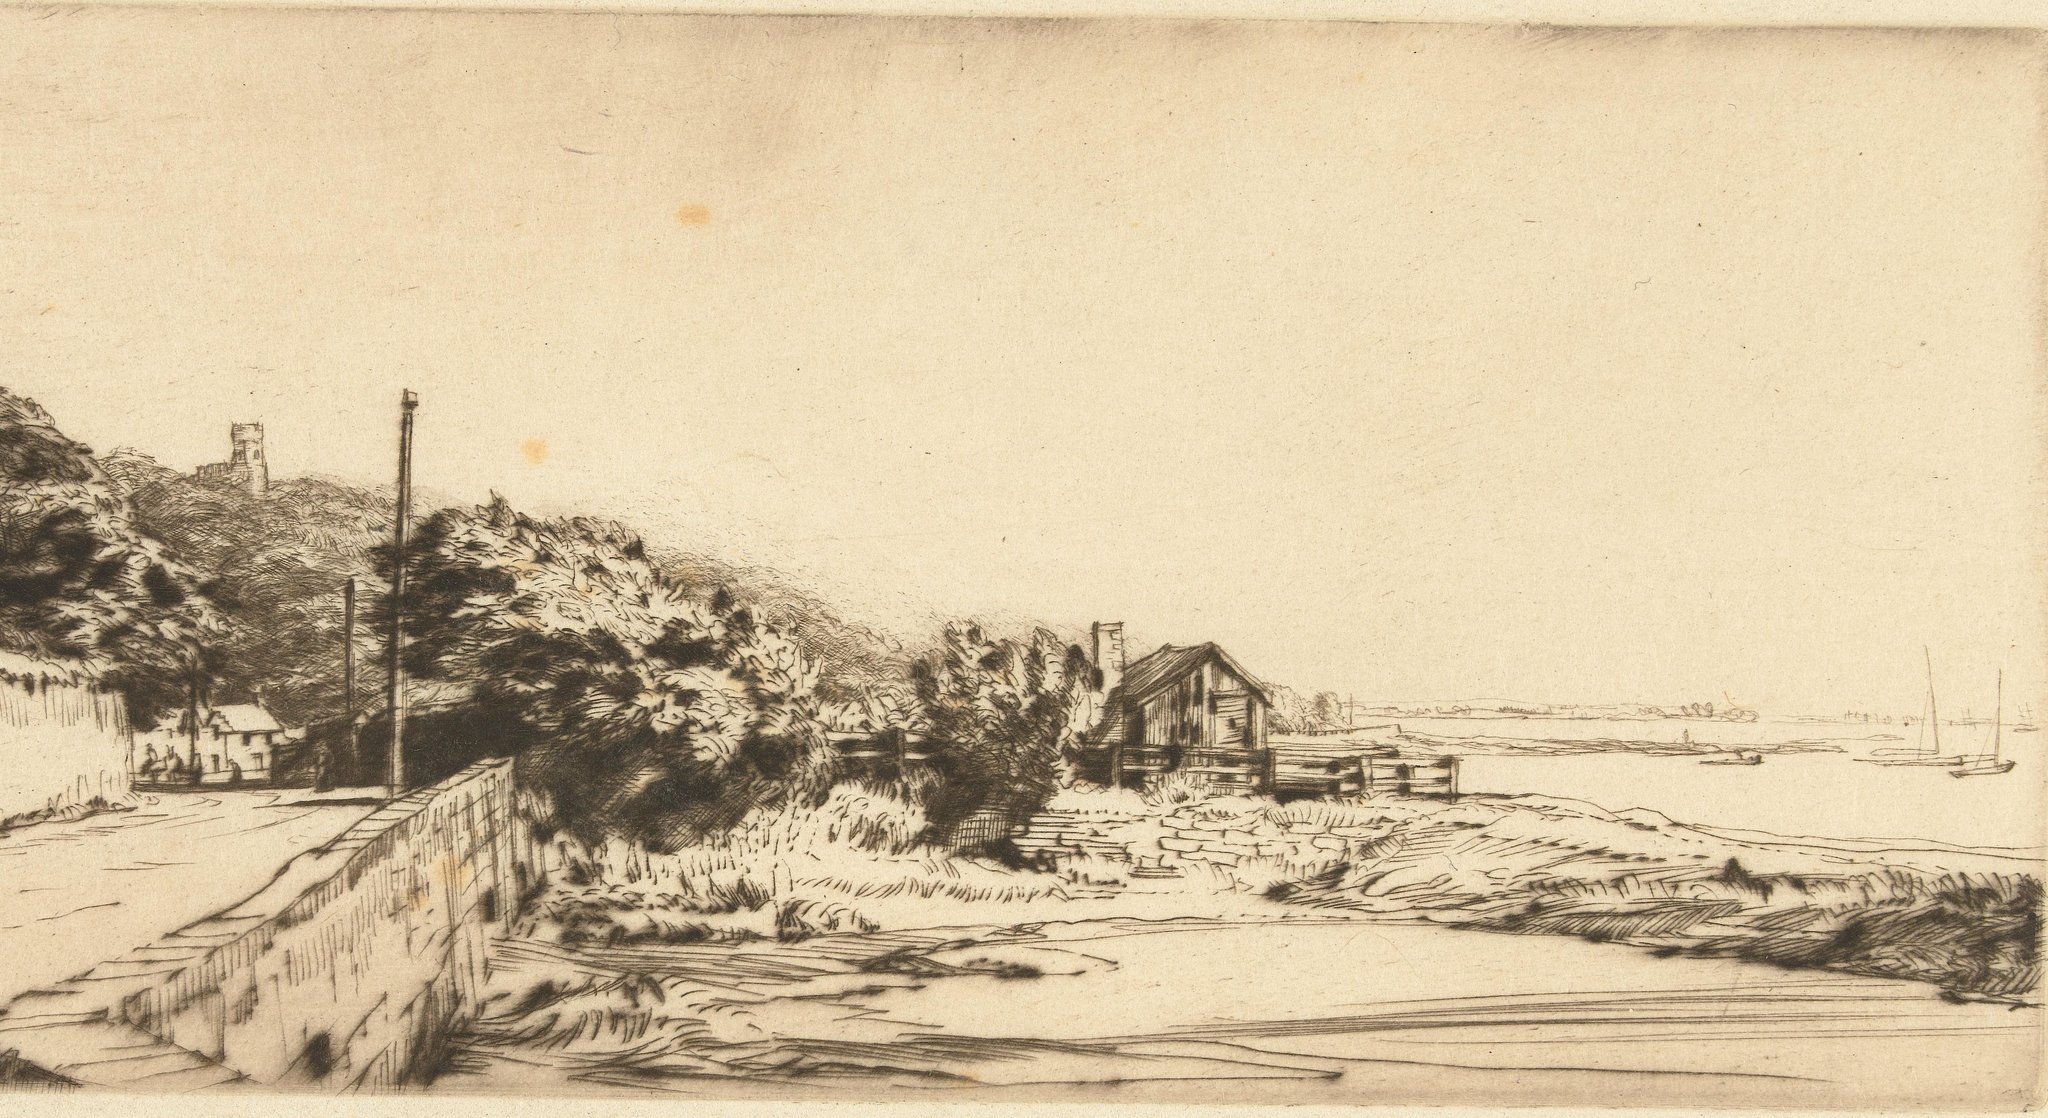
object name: print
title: Dunimarle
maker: muirhead bone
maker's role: artist, print maker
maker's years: 1876-1953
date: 1909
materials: paper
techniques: drypoint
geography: england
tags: river, road, path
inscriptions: signature: ‘Muirhead Bone’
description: Bemuurde landweg met een wandelende man, achter de muur vele bomen. Rechts een huis op de oever van een rivier waarop een aantal bootjes drijven.